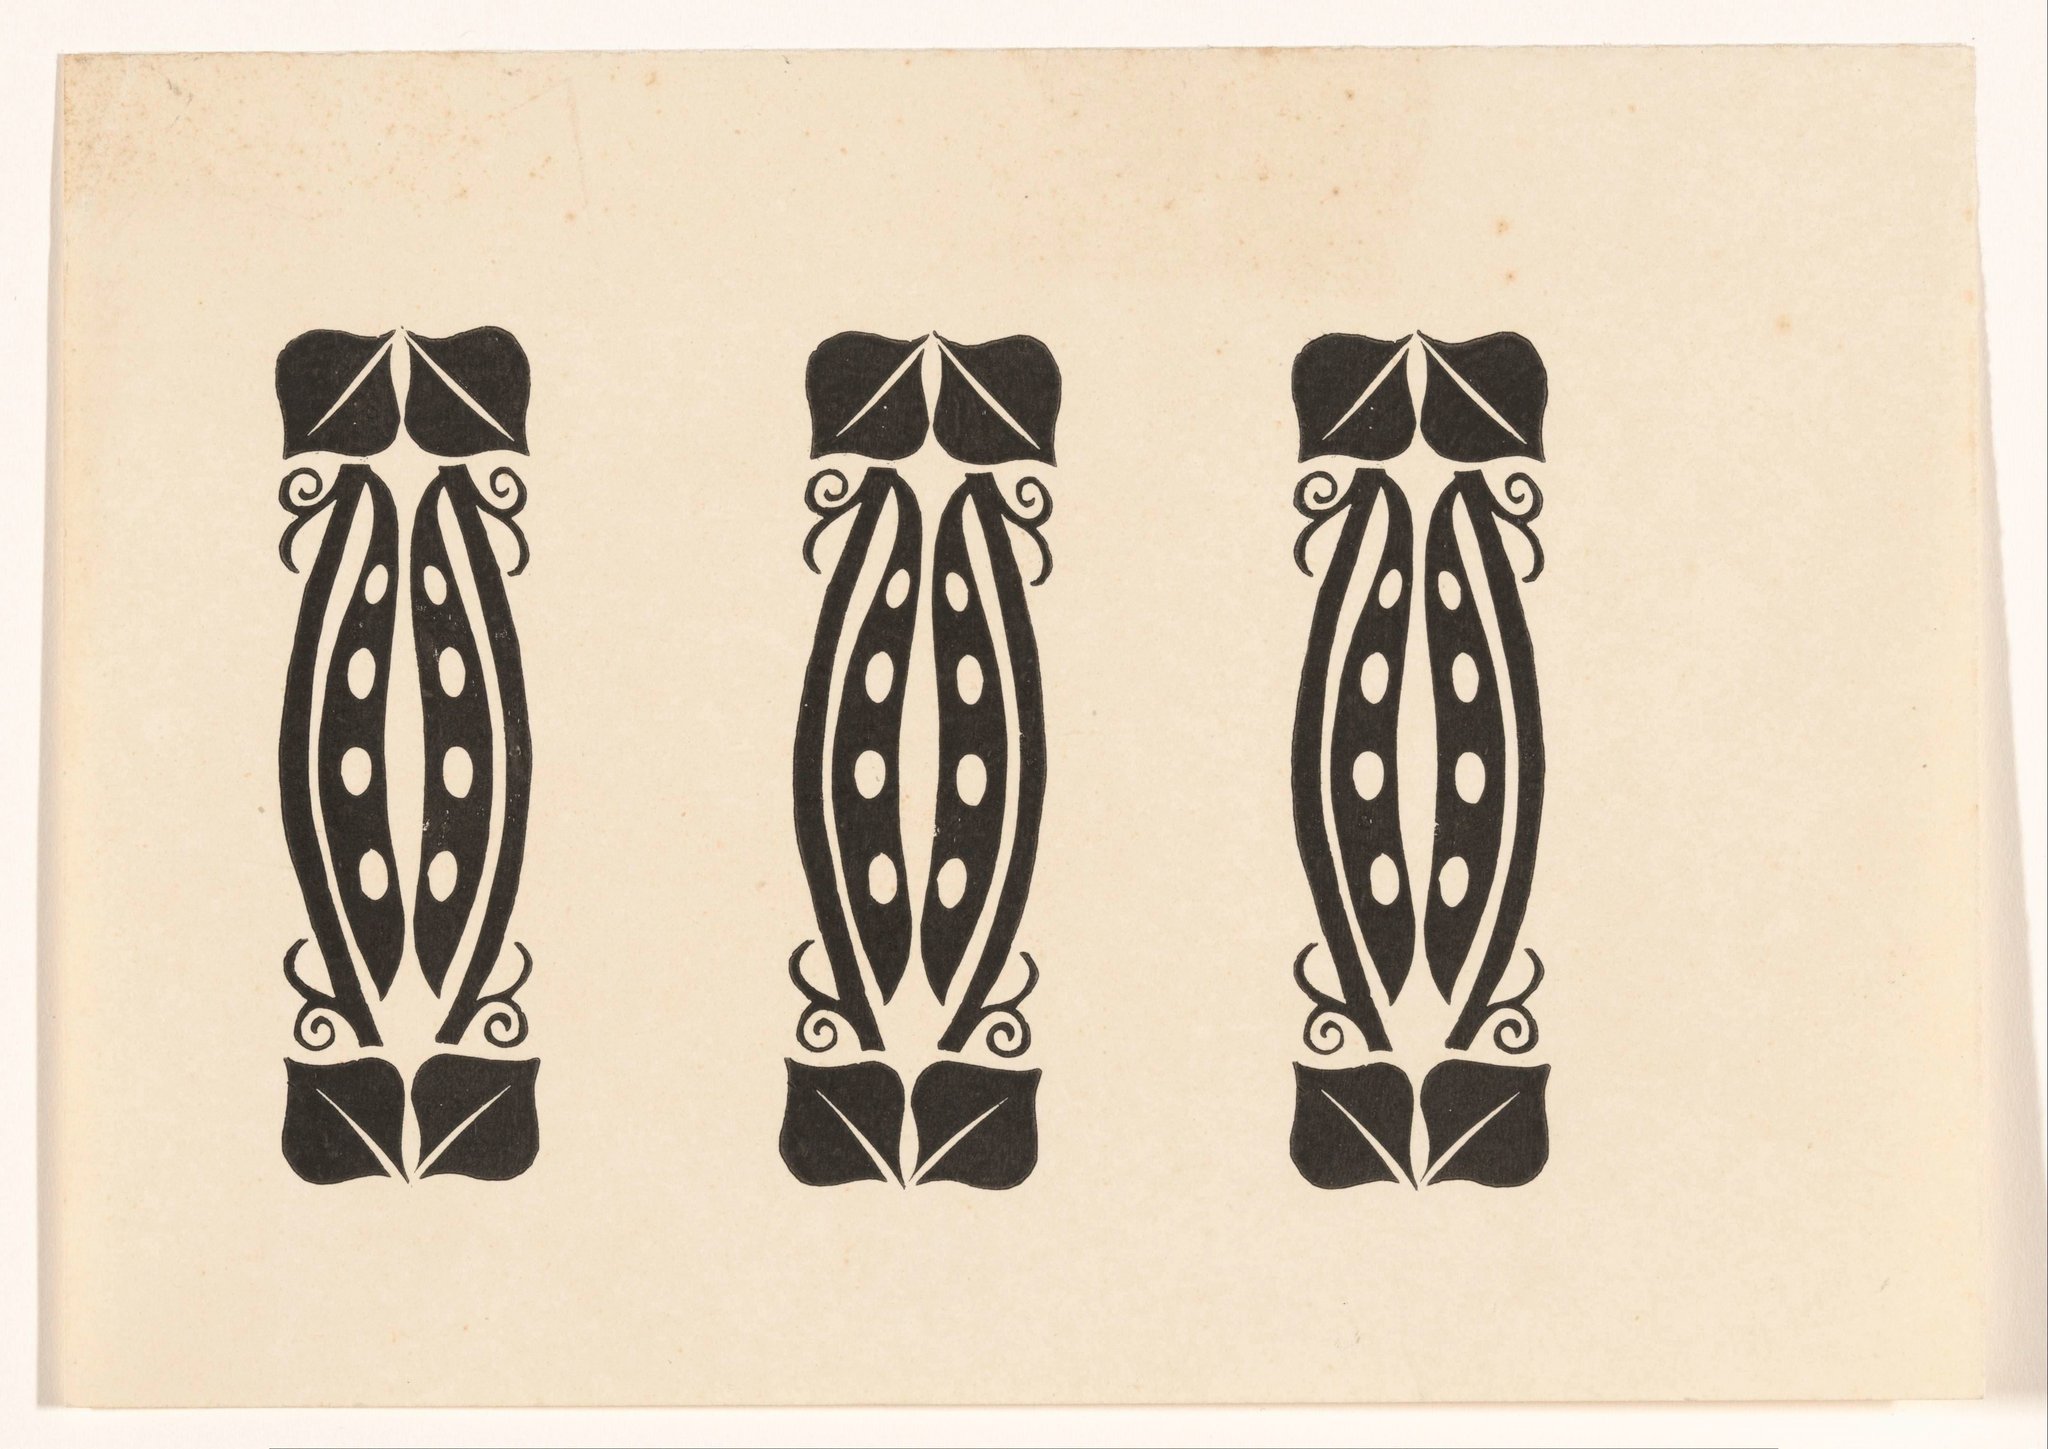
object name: print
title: Siermotief met drie peulvruchten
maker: carel adolph lion cachet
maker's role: draughtsman, print maker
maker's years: 1864-1945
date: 1874-1945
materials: paper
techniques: printing block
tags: ornament derived from plant forms - aa - stylized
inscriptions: collector's mark: Lugt 2228